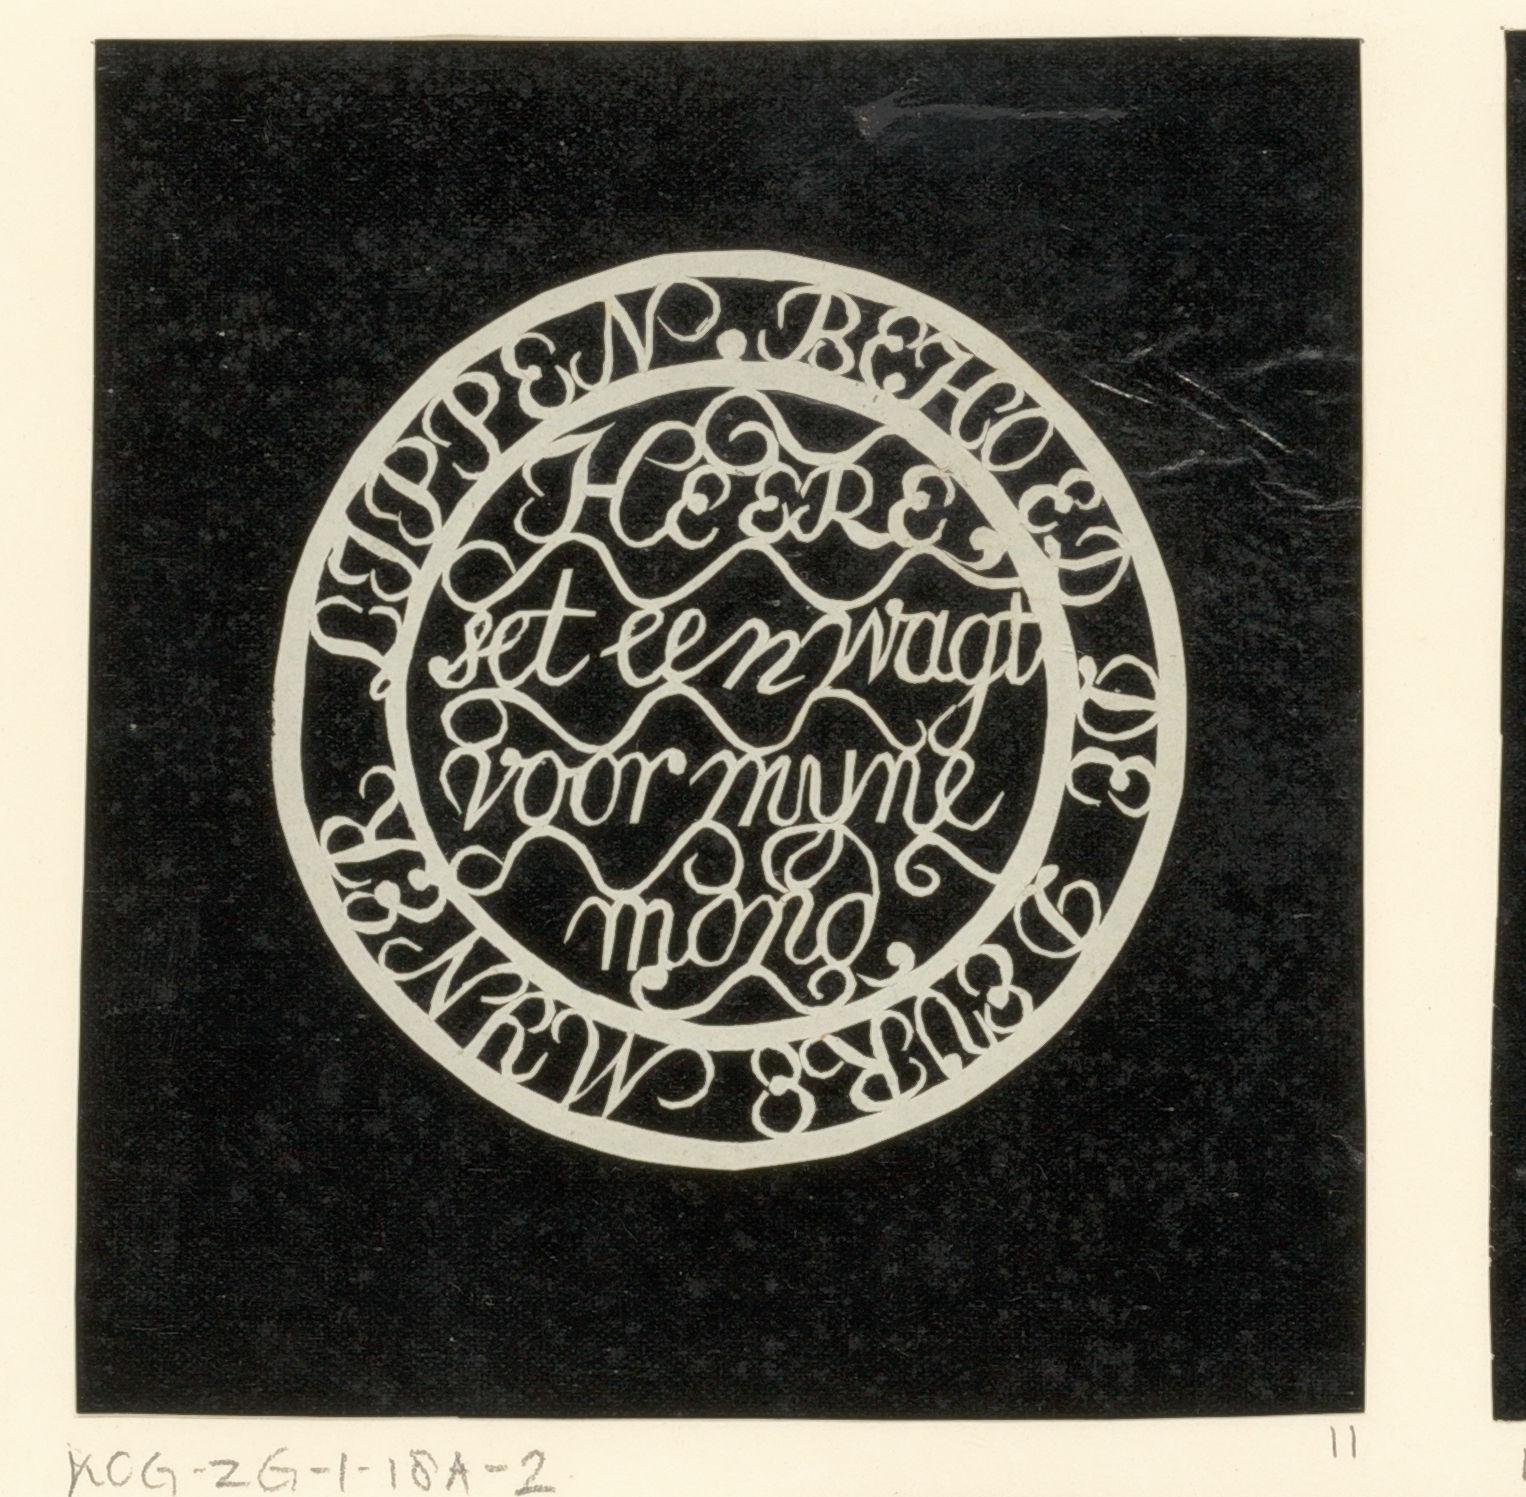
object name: cut paper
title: Spreuk: Heere, set een wagt voor mijne mond. Behoed de deure mijner Lippen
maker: Anonymous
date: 1750-1849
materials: paper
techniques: cutting, snipping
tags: word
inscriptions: collector's mark: Lugt 1641, stamp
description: De spreuk: Heere, set een wagt voor mijne mond. Behoed de deure mijner Lippen (Psalm 141 : 3). Onderwerpsrubrieken binnen de Atlas Zeden en Gewoonten: Schoone kunsten, Knipkunst.